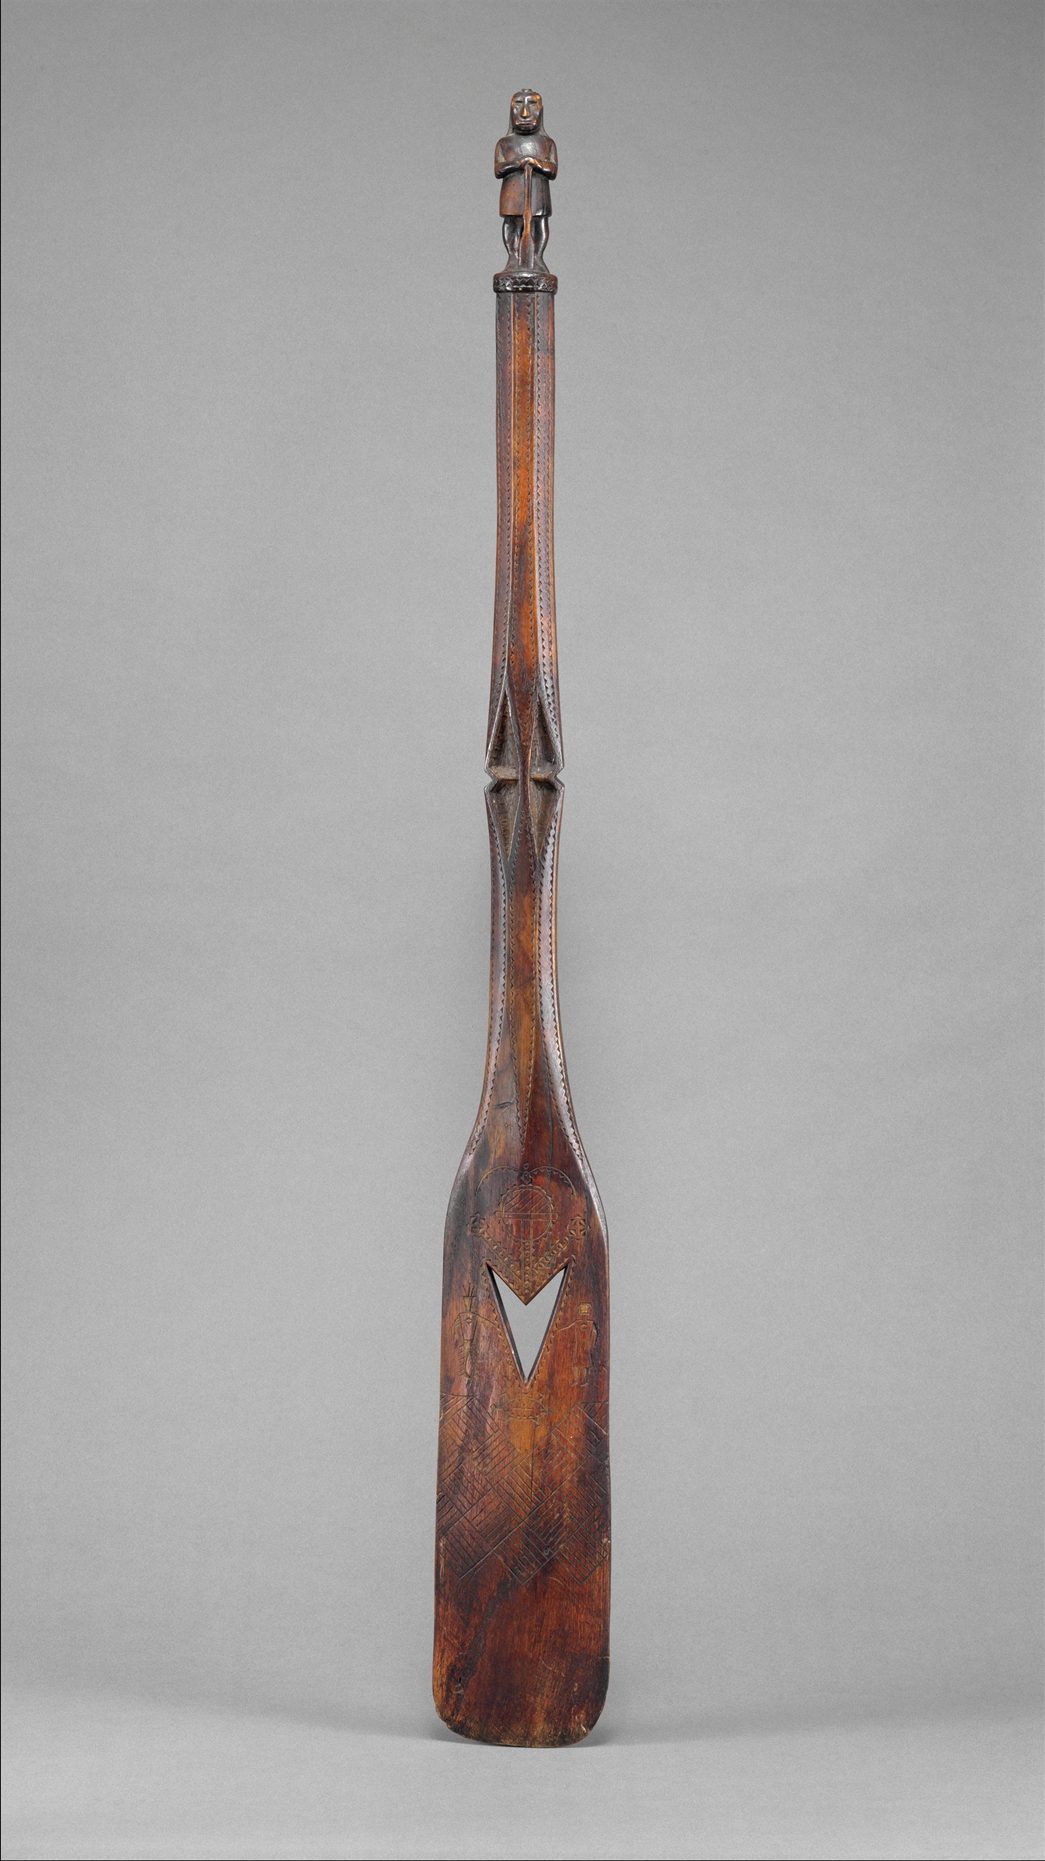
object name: paddle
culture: haudenosaunee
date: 1850-1875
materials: wood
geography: canada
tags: men